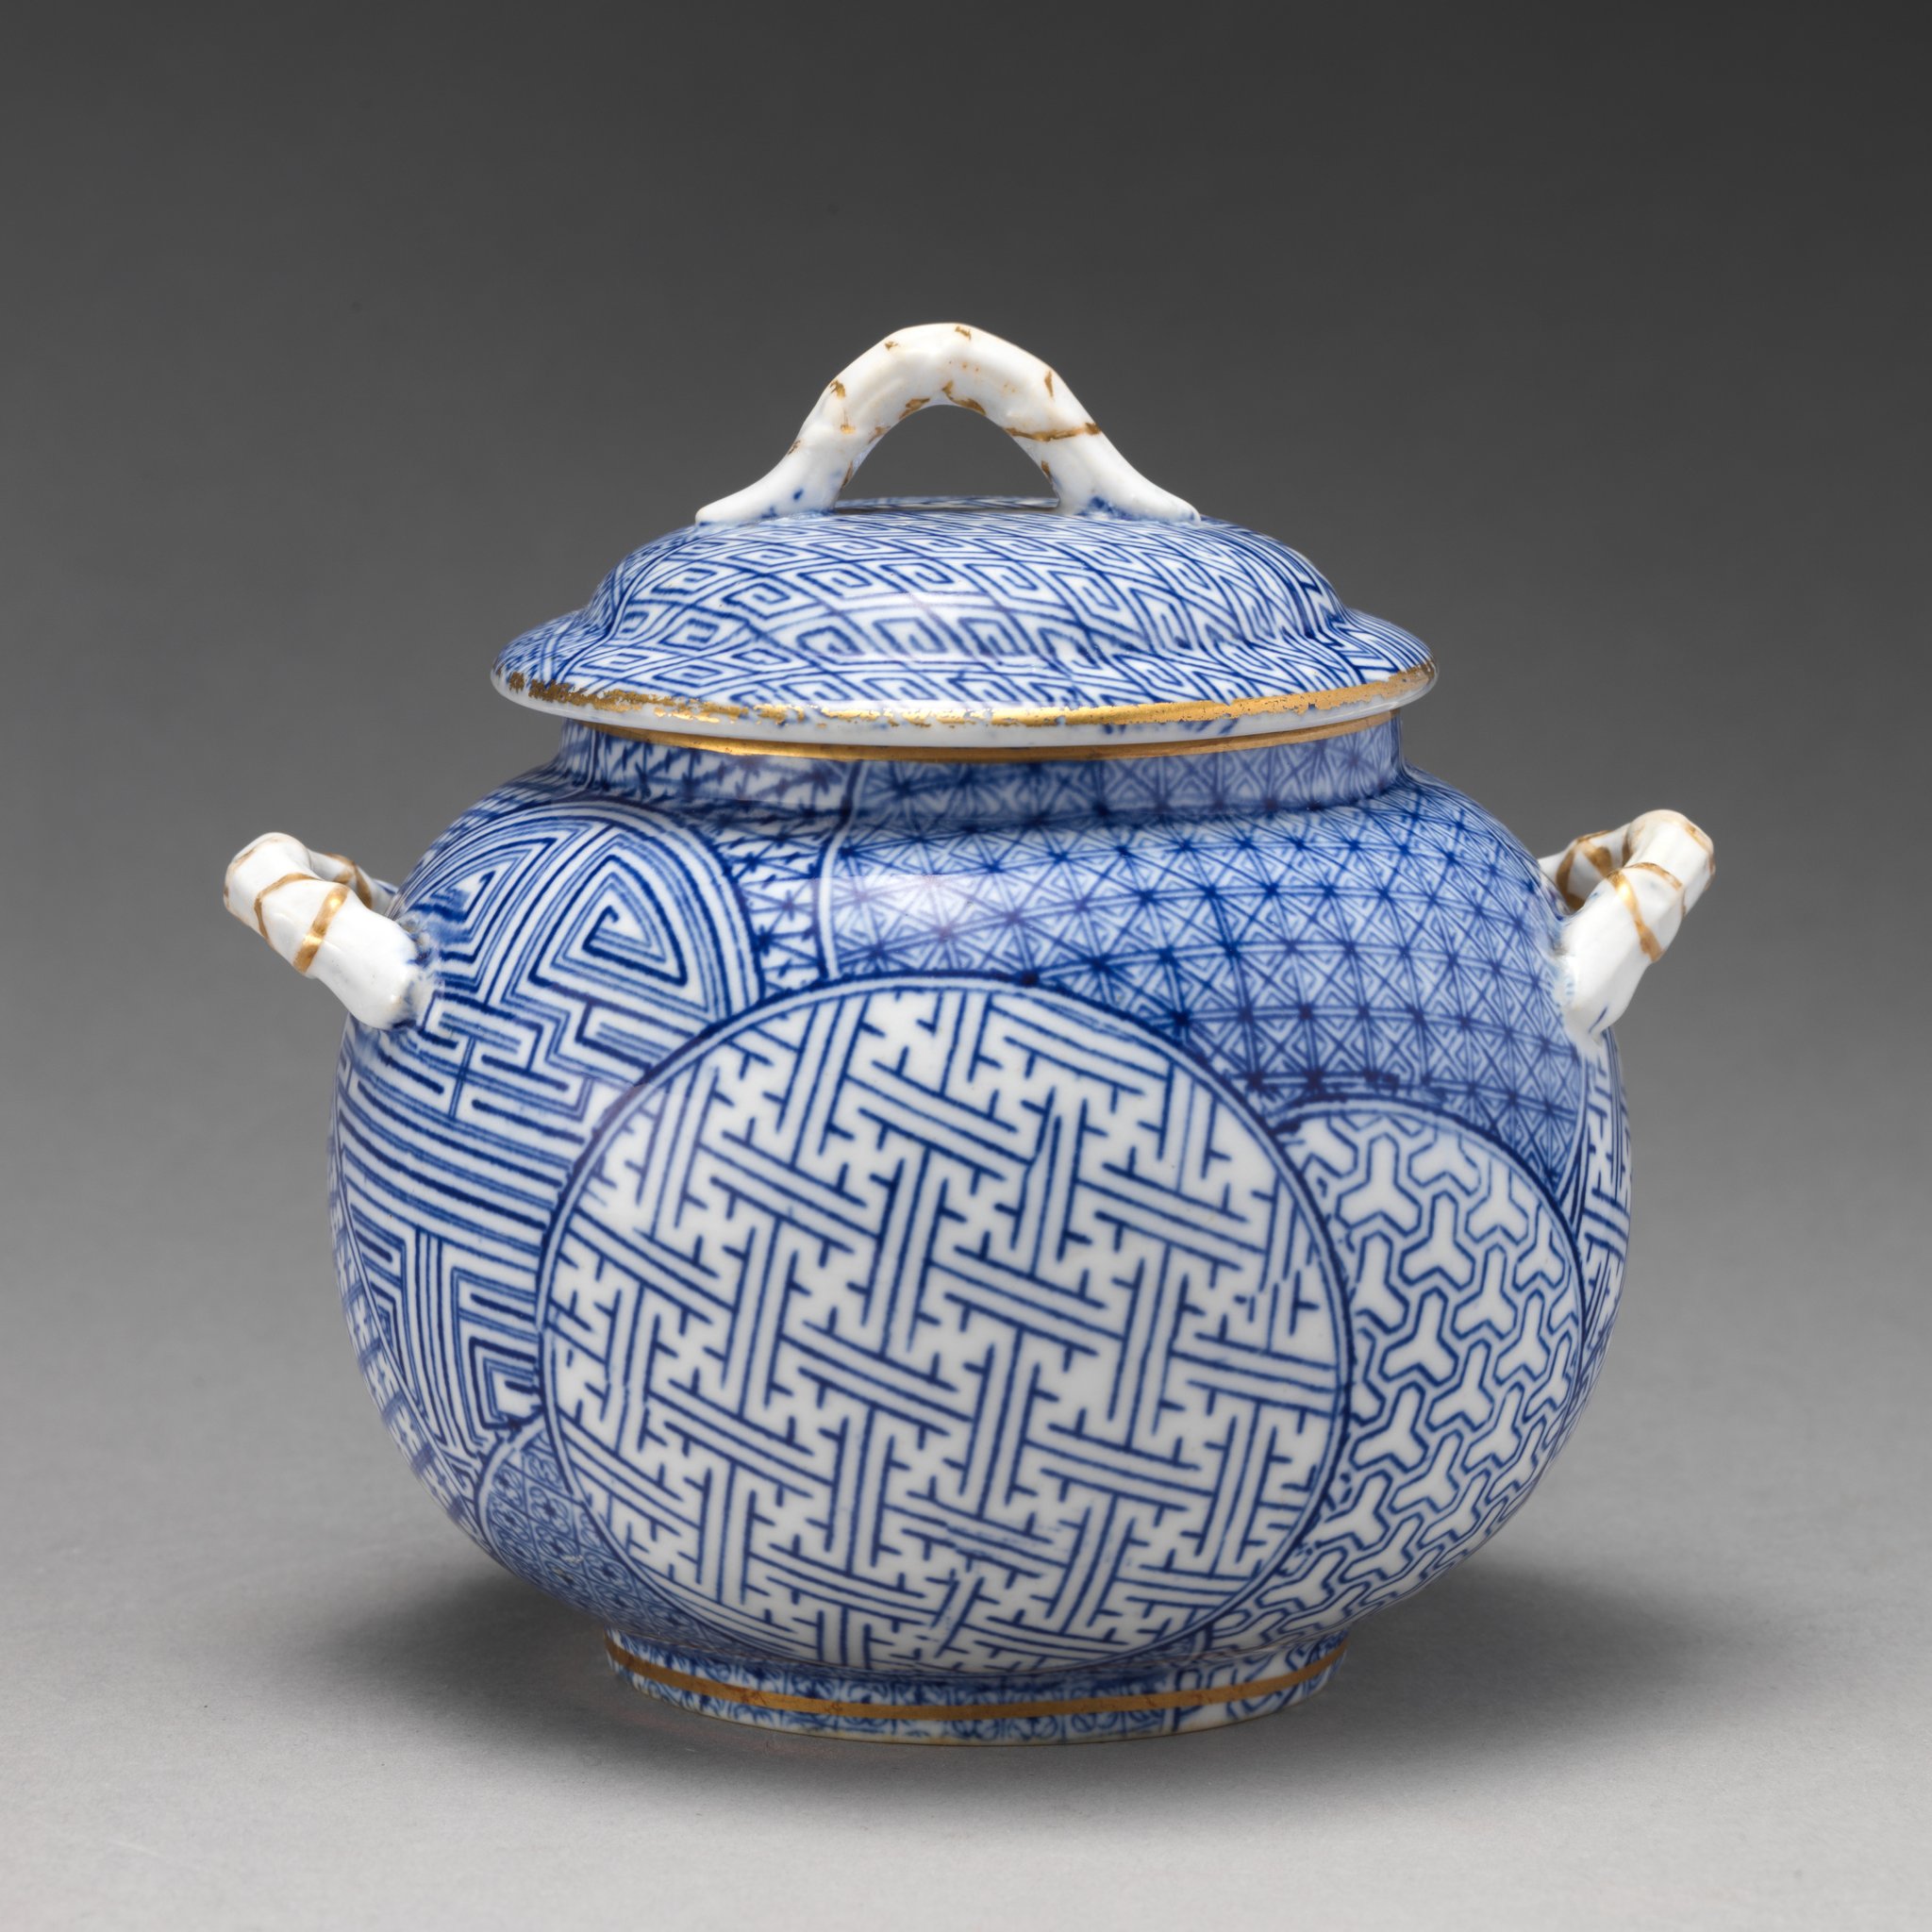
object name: lidded jar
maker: worcester factory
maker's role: maker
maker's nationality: british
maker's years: 1751-2008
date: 1882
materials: bone china